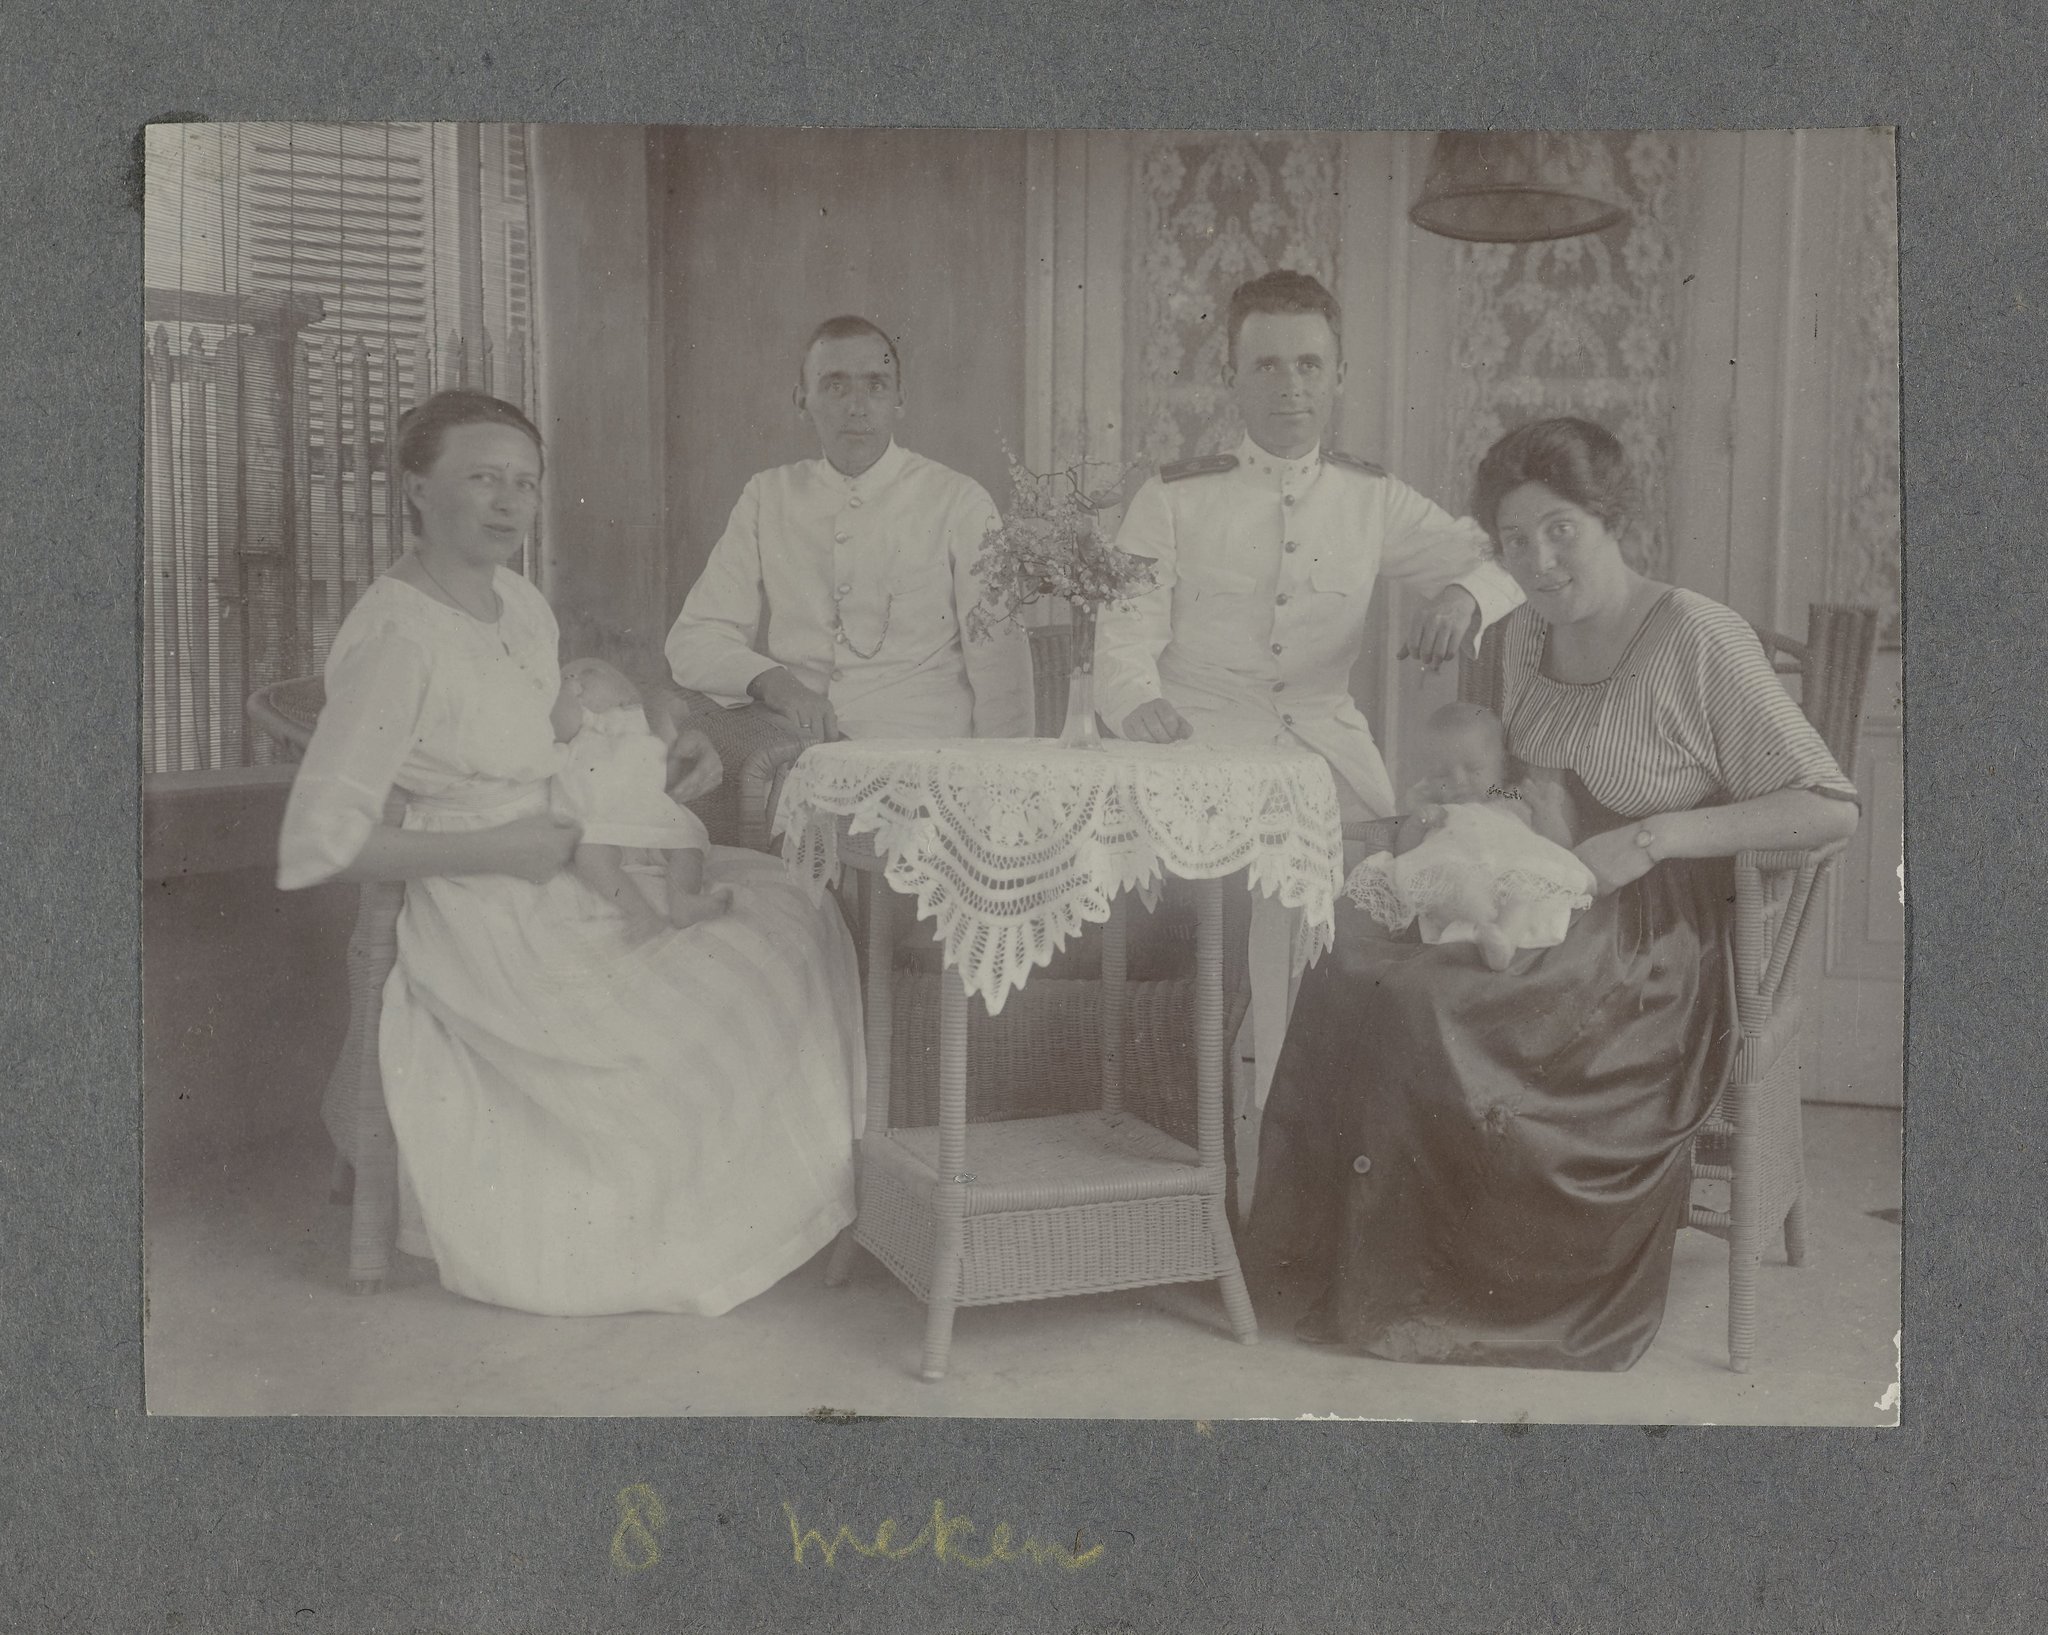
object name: photograph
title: Twee stellen met baby's waaronder Klaas Kleiterp en zijn vrouw Tine Kleiterp-Vermeulen met 8 weken oude Klaas (rechts) in Malang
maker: klaas kleiterp (i)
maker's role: arts, officier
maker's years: 1892-1943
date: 1920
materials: paper, photographic support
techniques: daylight paper print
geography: malang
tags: family group, especially parents with their child(ren), dutch east indies, the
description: Onderdeel van Fotoalbum van de familie Kleiterp-Vermeulen met opnames van de kinderen Klaas en Tiny in Nederlands-Indië.